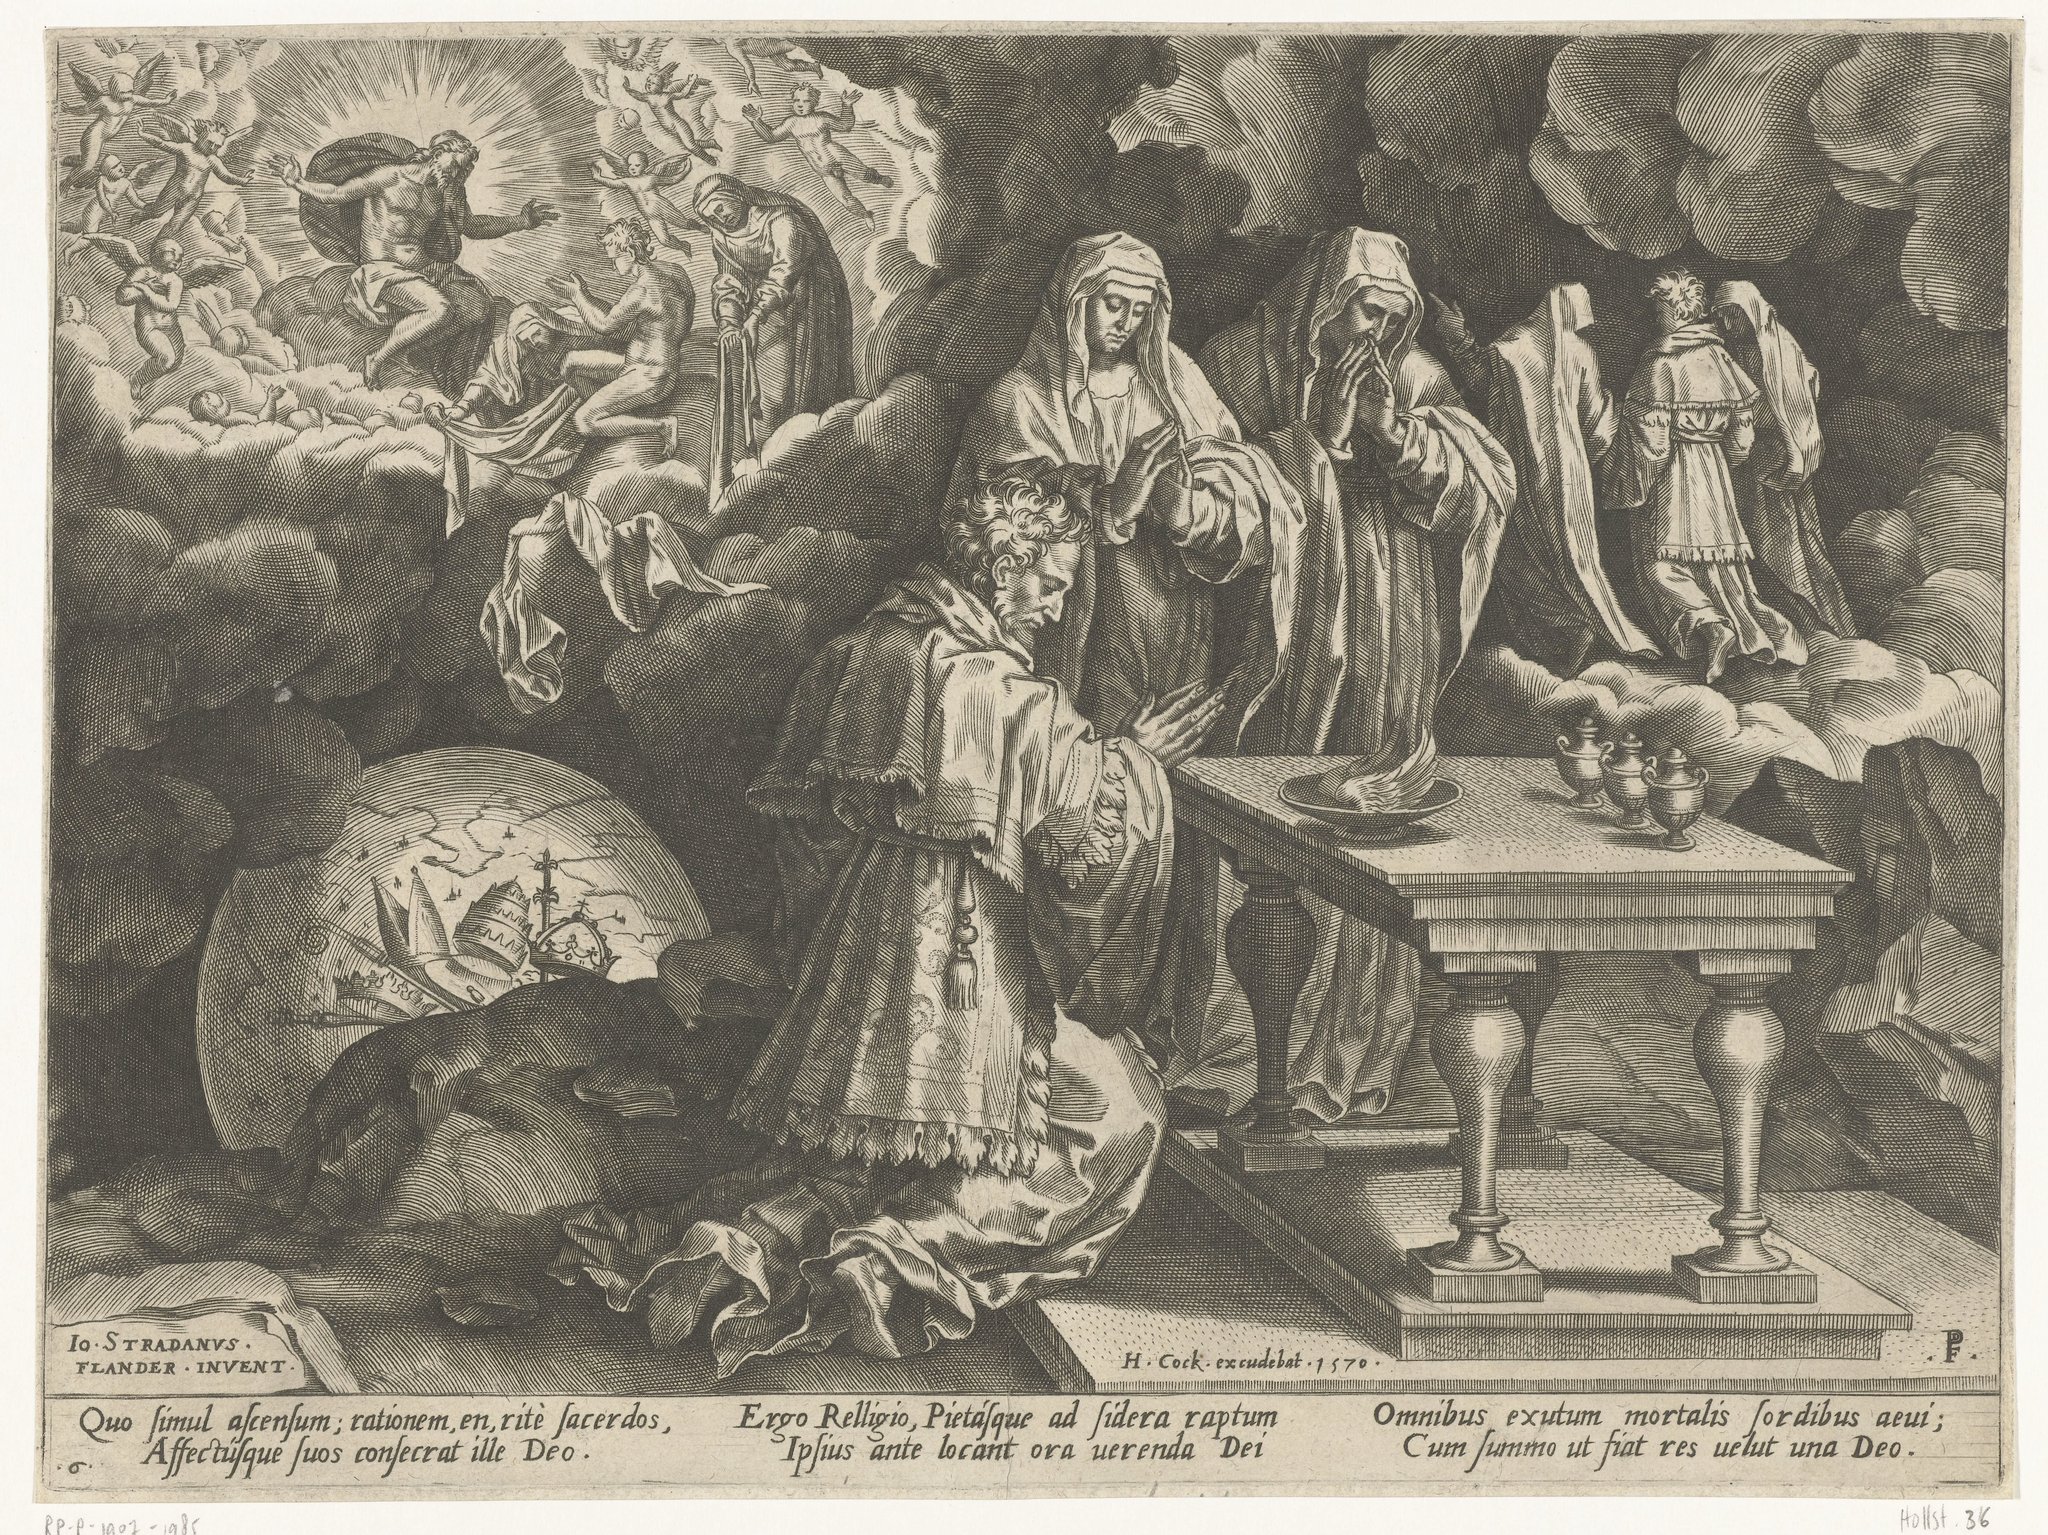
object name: print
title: Allegorie op het leven van de mens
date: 1570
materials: paper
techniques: engraving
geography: antwerp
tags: old age, 'senectus'; 'vecchiezza' (ripa), journey to heaven, pathway to heaven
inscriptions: collector's mark: Lugt 2228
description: Een volwassen man zit met de handen ineengevouwen geknield voor een tafel. Samen met twee gesluierde vrouwen aanbidt hij een schaal waarop twee vleugels liggen. Links naast de man ligt een bol met de beeltenis van verschillende mijters en een kroon deels verzonken in de aarde. Hierboven is Christus aan de hemel verschenen, omringd door engelen. Een naakt man, rechts in de voorstelling naar Christus geleid door de personificaties van Religie en Vroomheid, zit geknield voor Christus. Onder de voorstelling staat een tekst in het Latijn, links in de marge genummerd: 6. De prent maakt deel uit van een serie allegorische prenten op het leven van de mens.